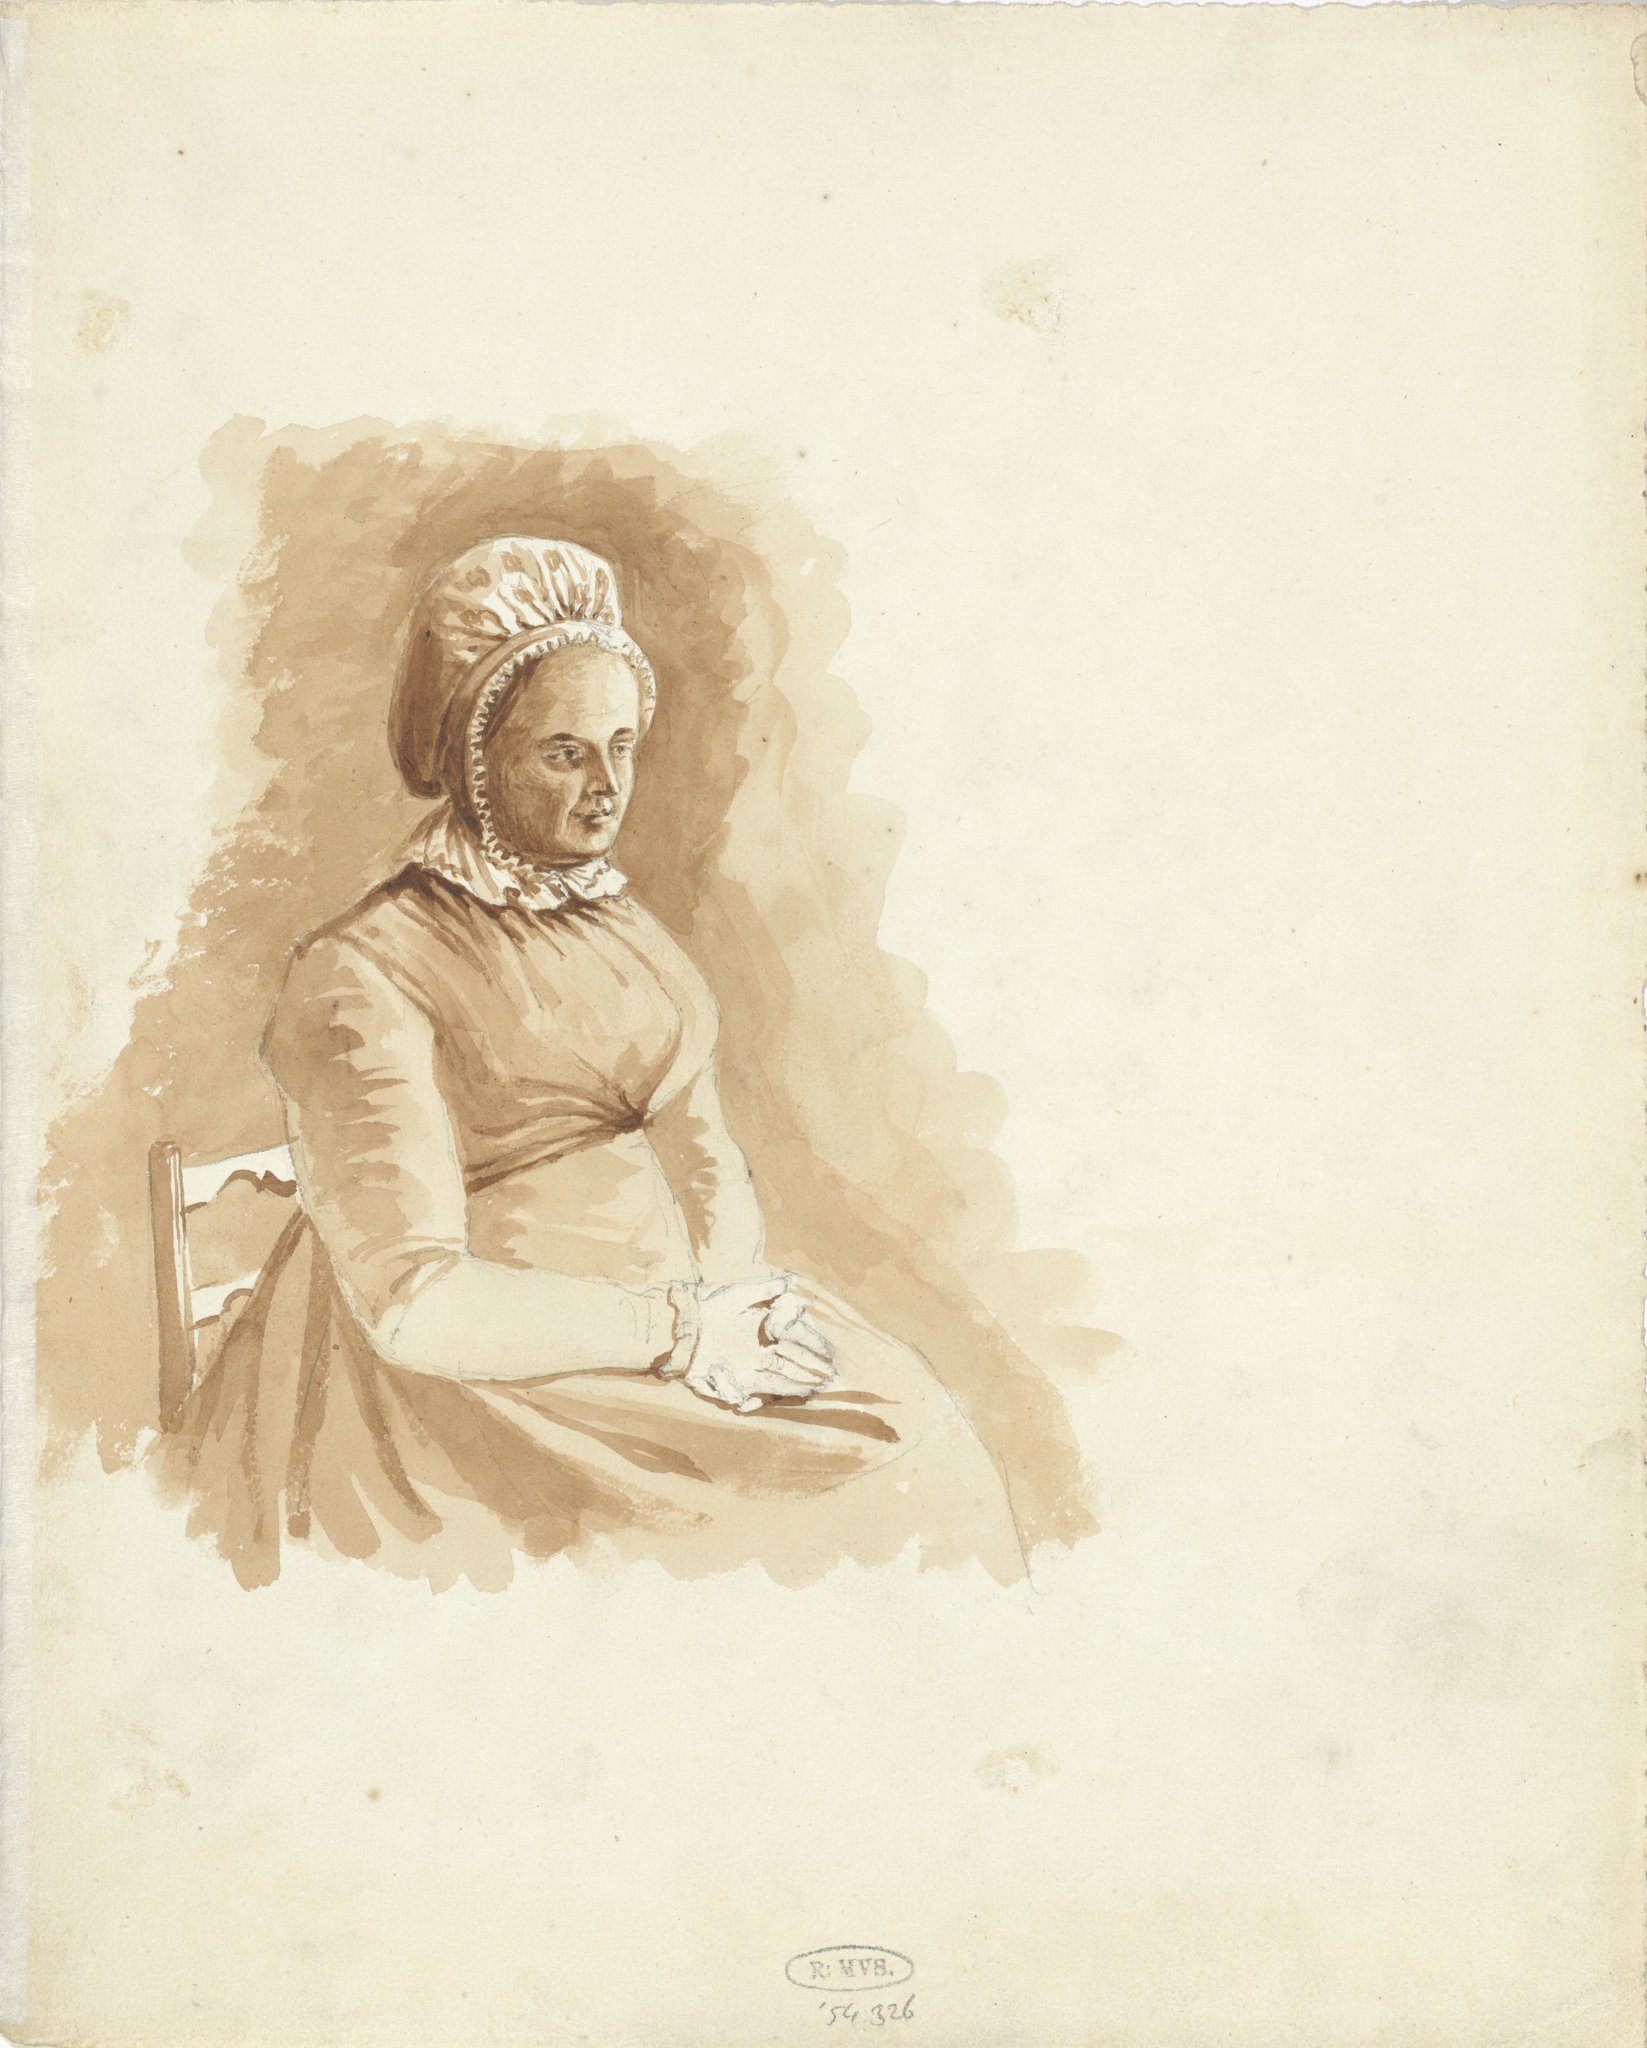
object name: drawing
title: Zittende vrouw met gevouwen handen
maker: pieter van loon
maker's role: draughtsman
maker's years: 1801-1873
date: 1811-1873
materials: paper, pencil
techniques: brush